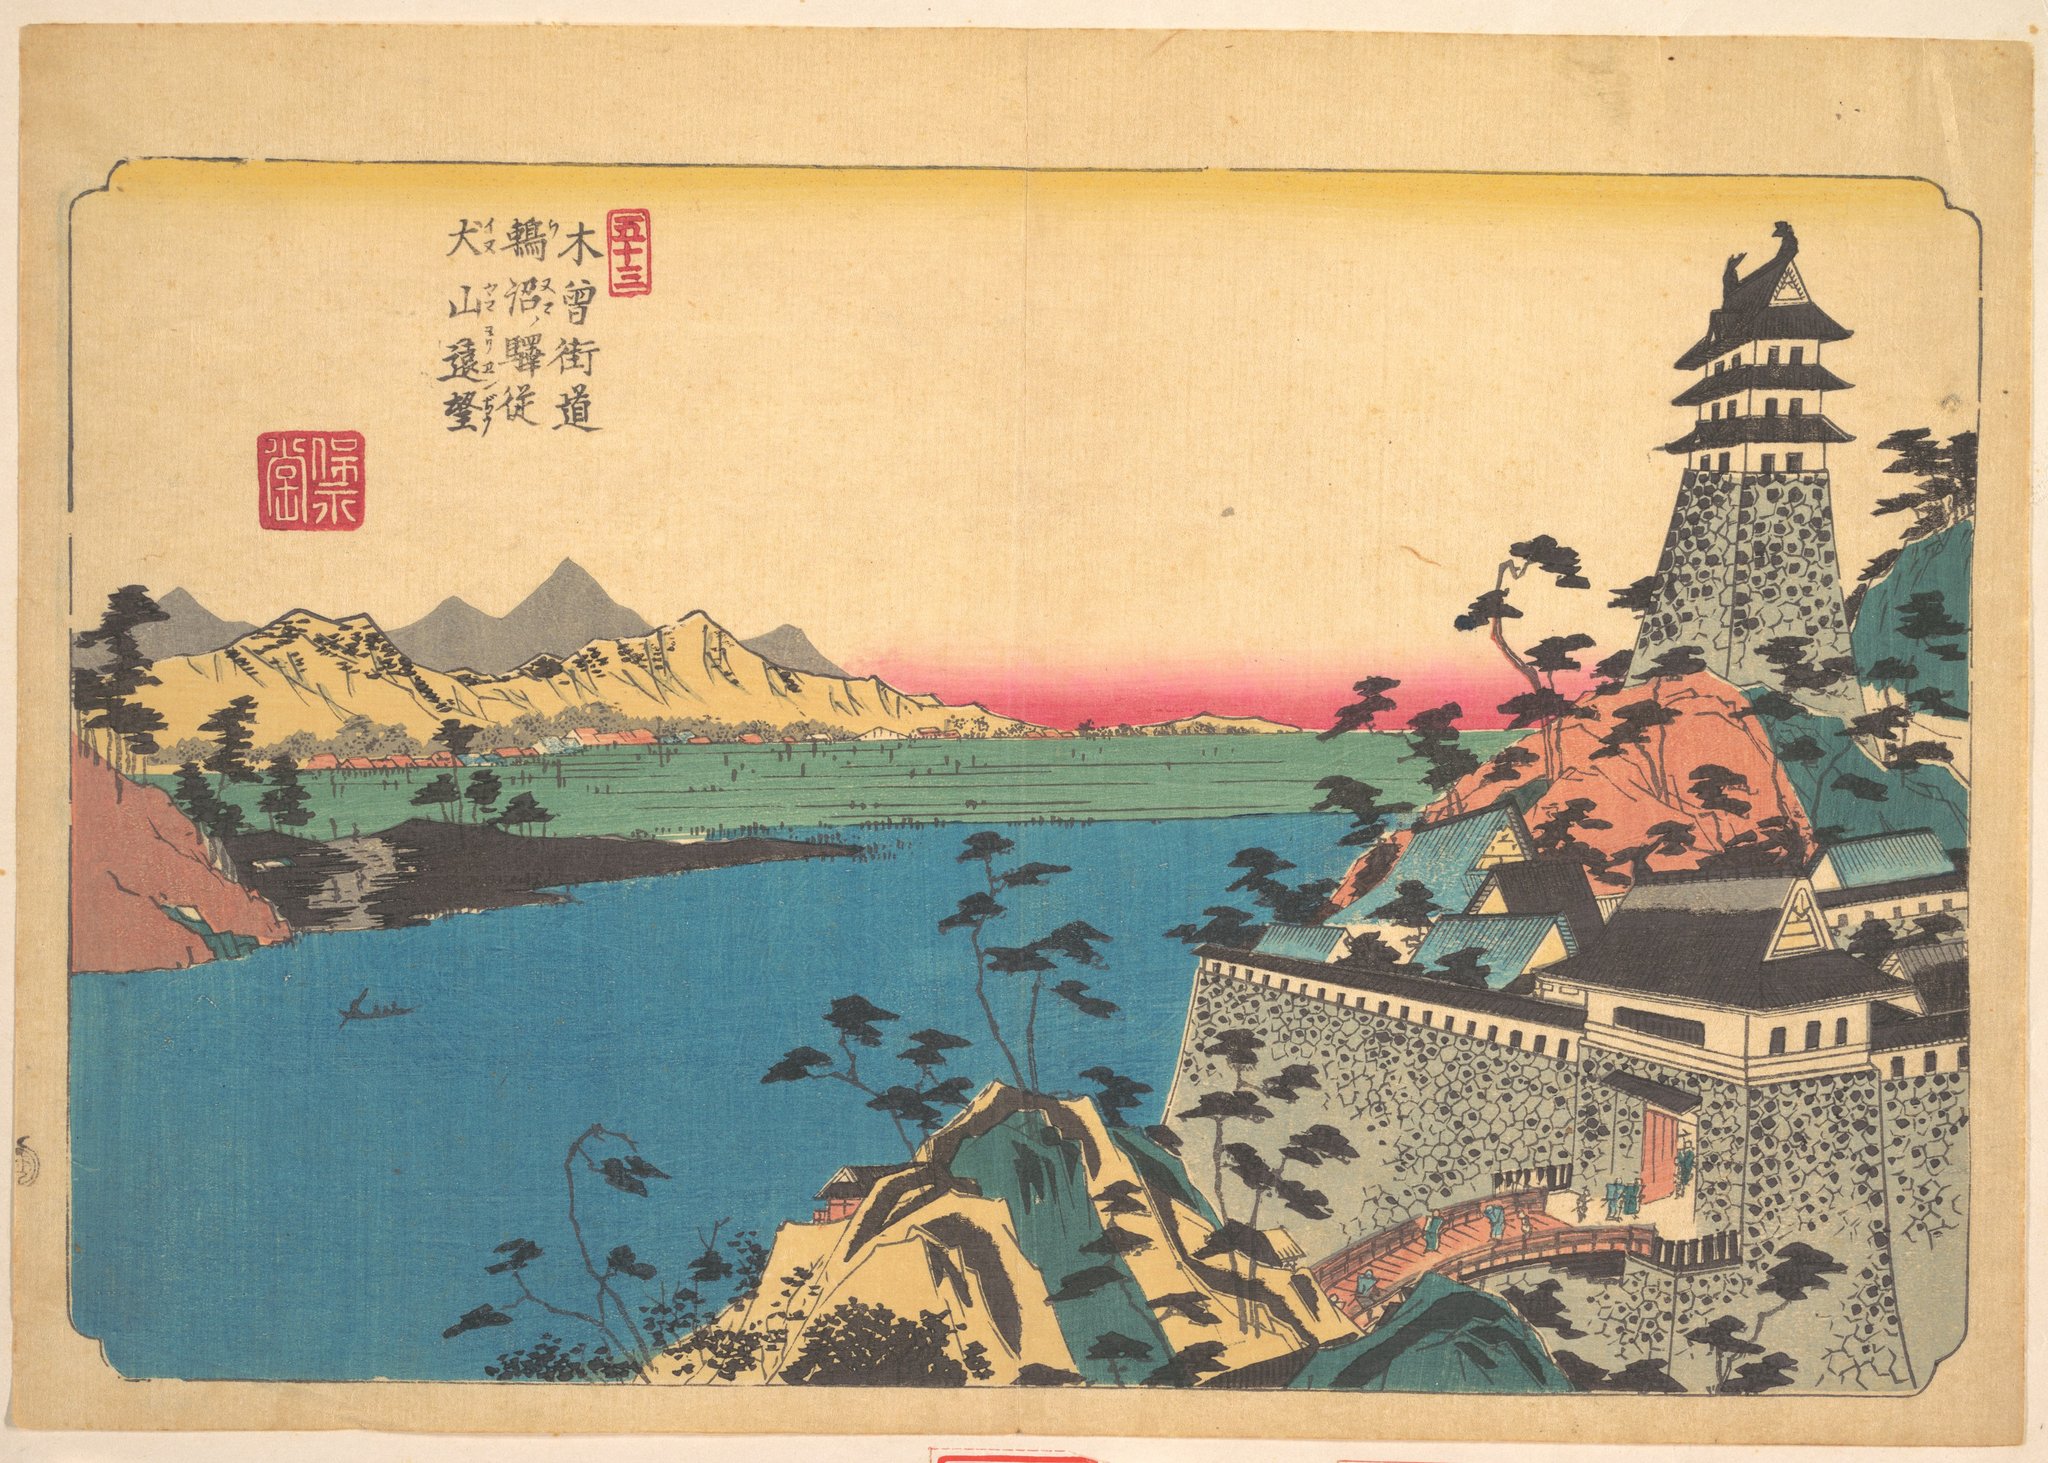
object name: print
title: The Castle of Unuma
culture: japanese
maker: keisai eisen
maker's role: artist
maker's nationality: japanese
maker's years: 1790-1848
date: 1801-1900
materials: ink, paper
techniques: woodblock print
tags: castles,bridges,hills,landscapes